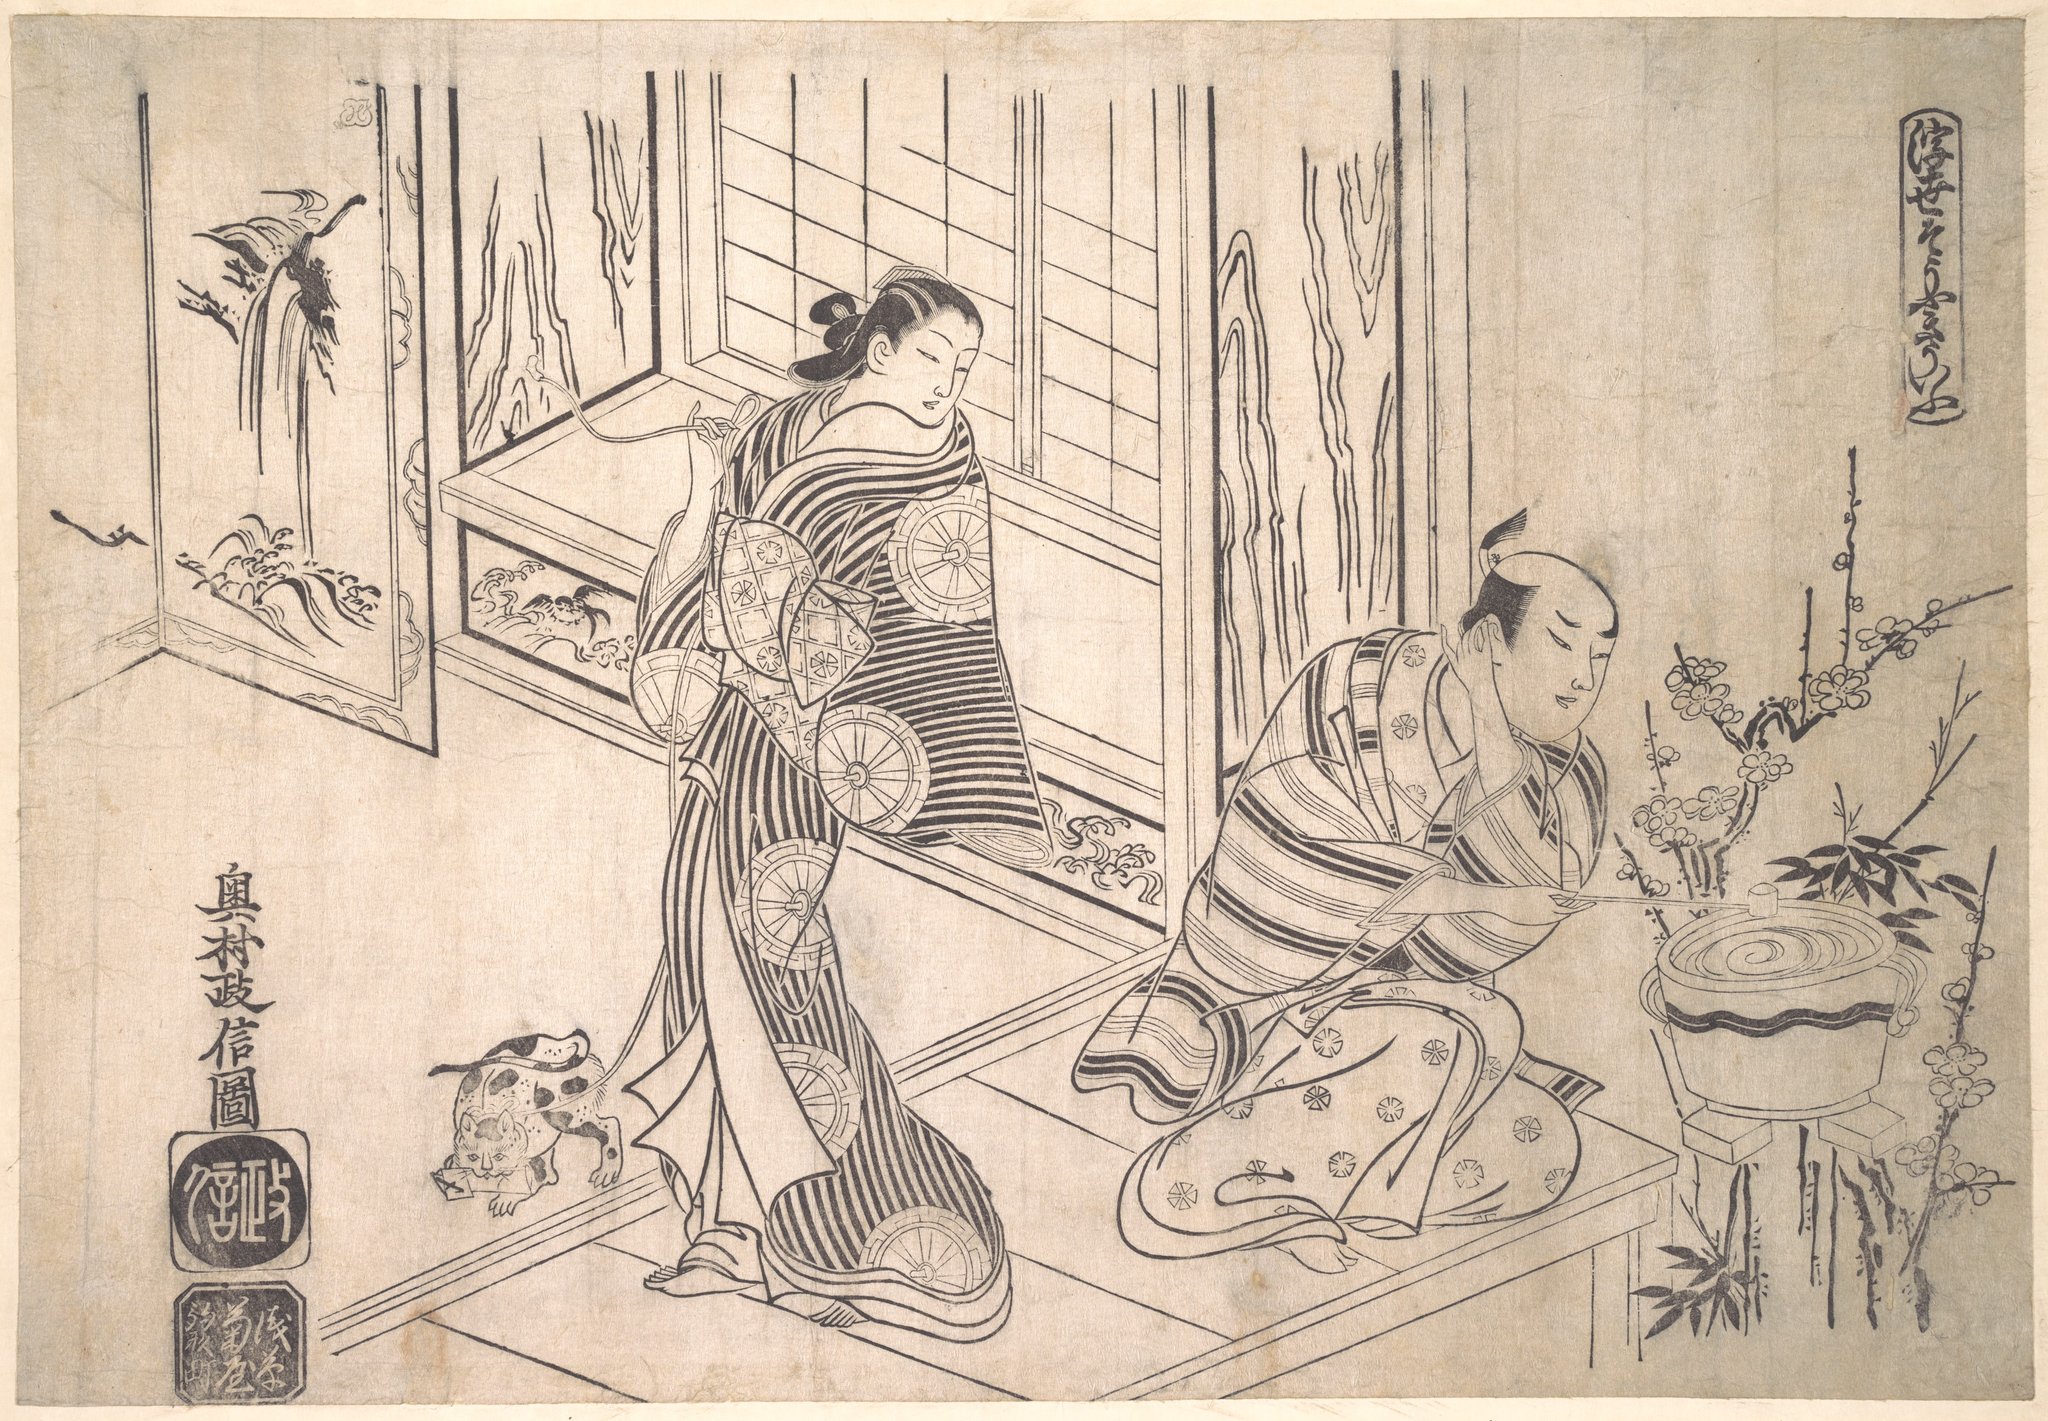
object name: print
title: Parody of the Legend of Xu You and Chao Fu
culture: japanese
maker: okumura masanobu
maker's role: artist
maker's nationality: japanese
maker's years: 1686-1764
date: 1715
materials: ink, paper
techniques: woodblock print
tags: men,women,cats,actors